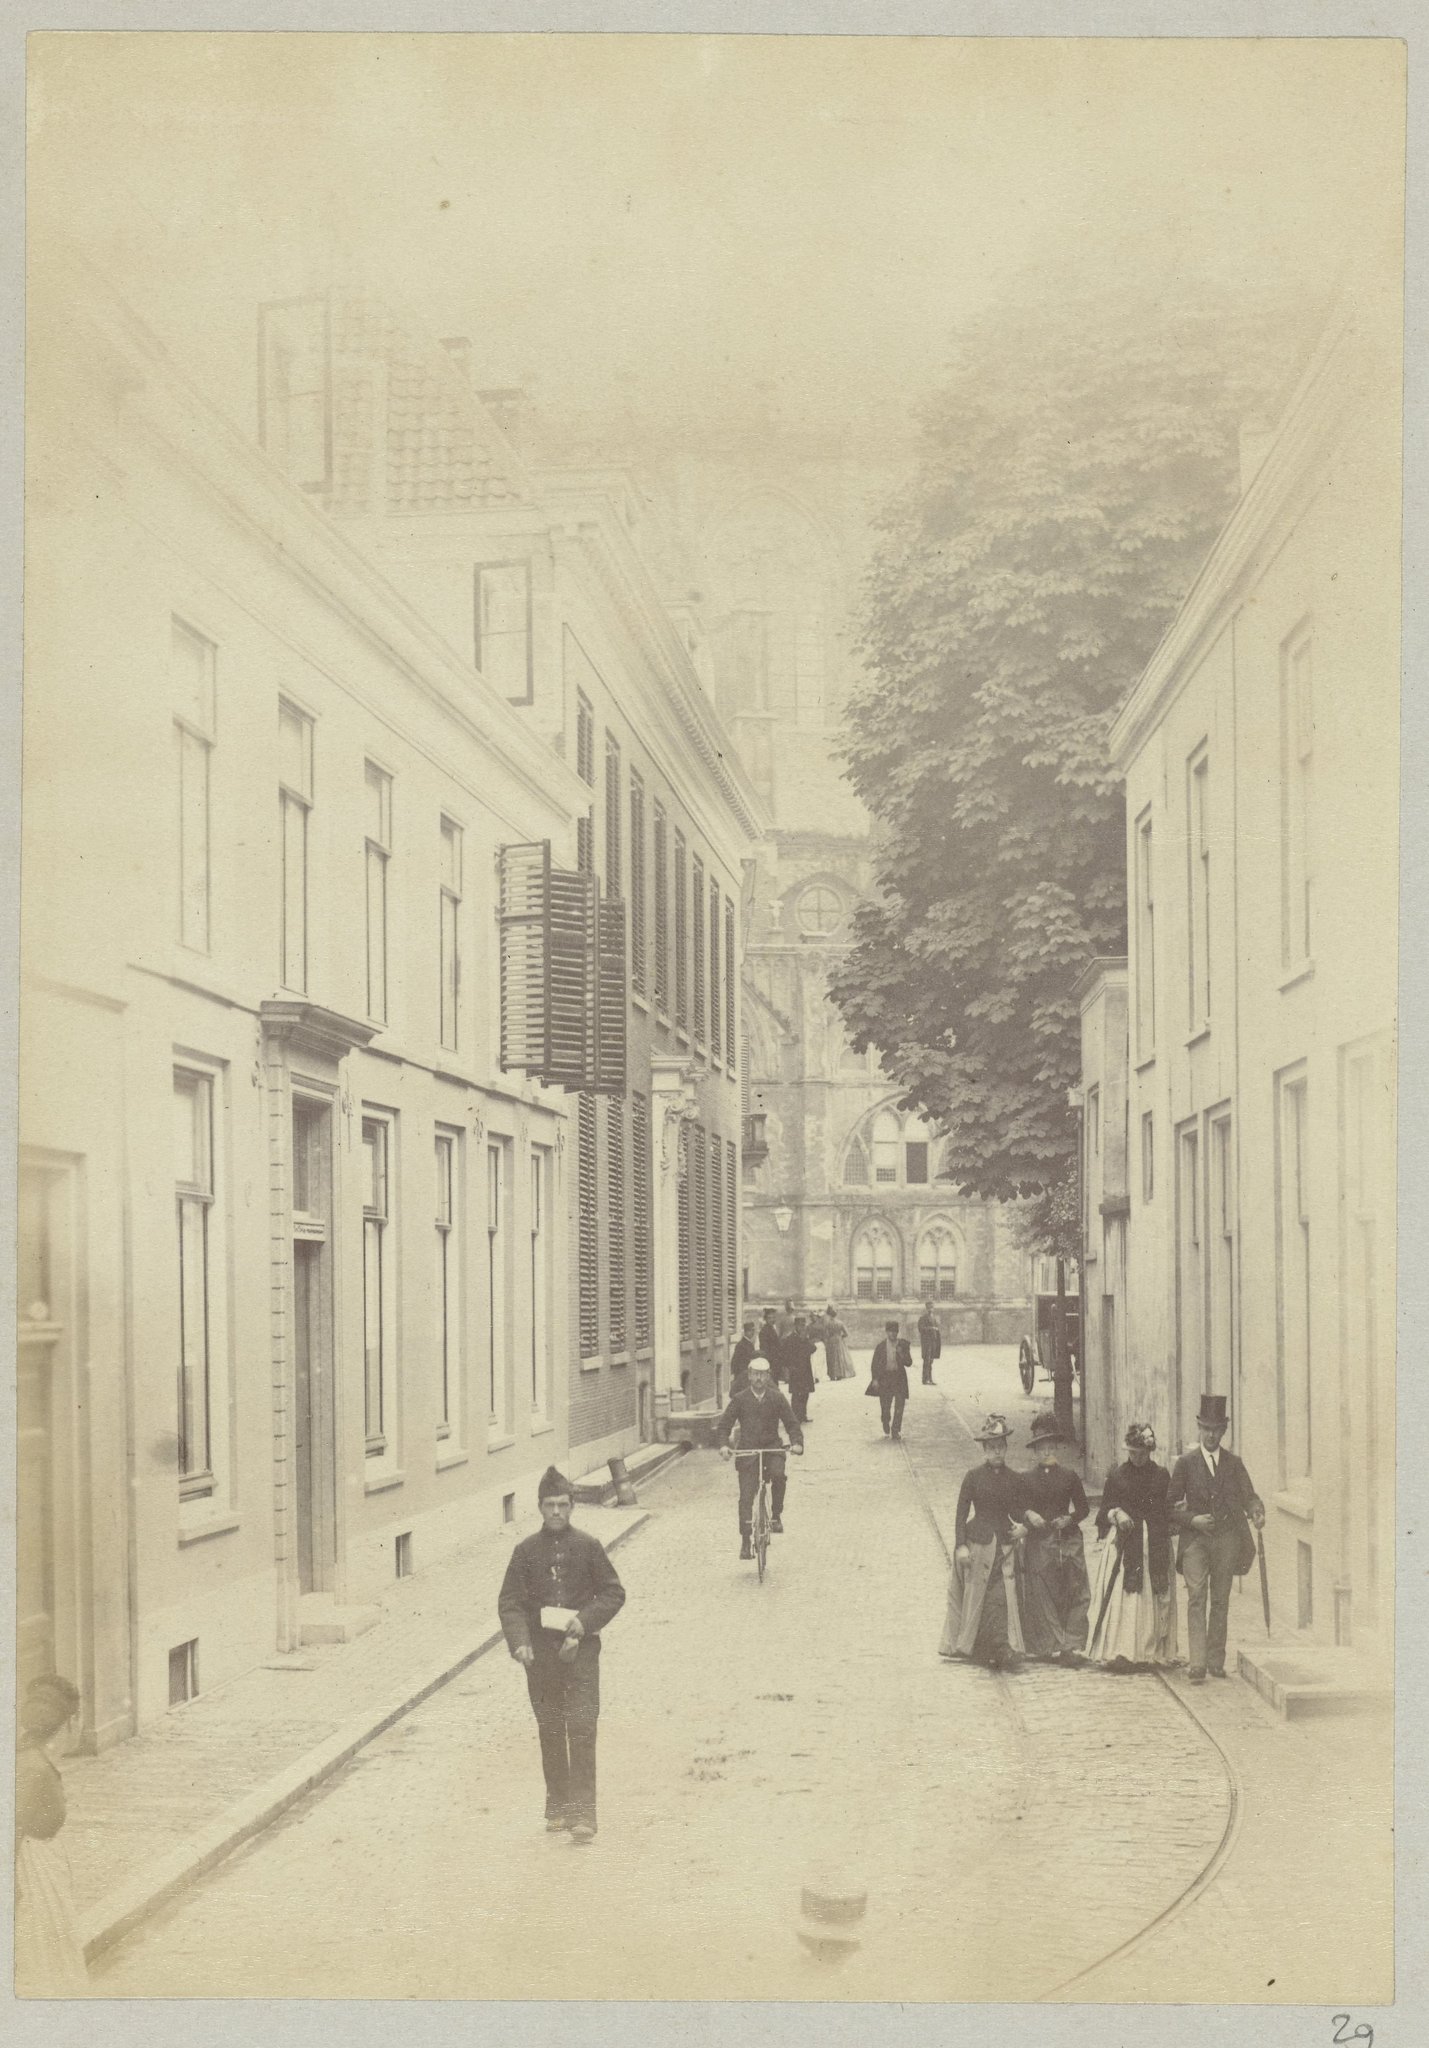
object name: photograph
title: Domstraat in Utrecht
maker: henry pauw van wieldrecht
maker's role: fotograaf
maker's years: 1863-1912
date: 1888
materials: paper, photographic support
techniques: albumen print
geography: netherlands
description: De Domstraat in Utrecht, met door de straat een tramrails en wandelende mensen. Geschreven op object: Domsteeg. Utrecht, gezicht uit kamer achter St. Pieter.